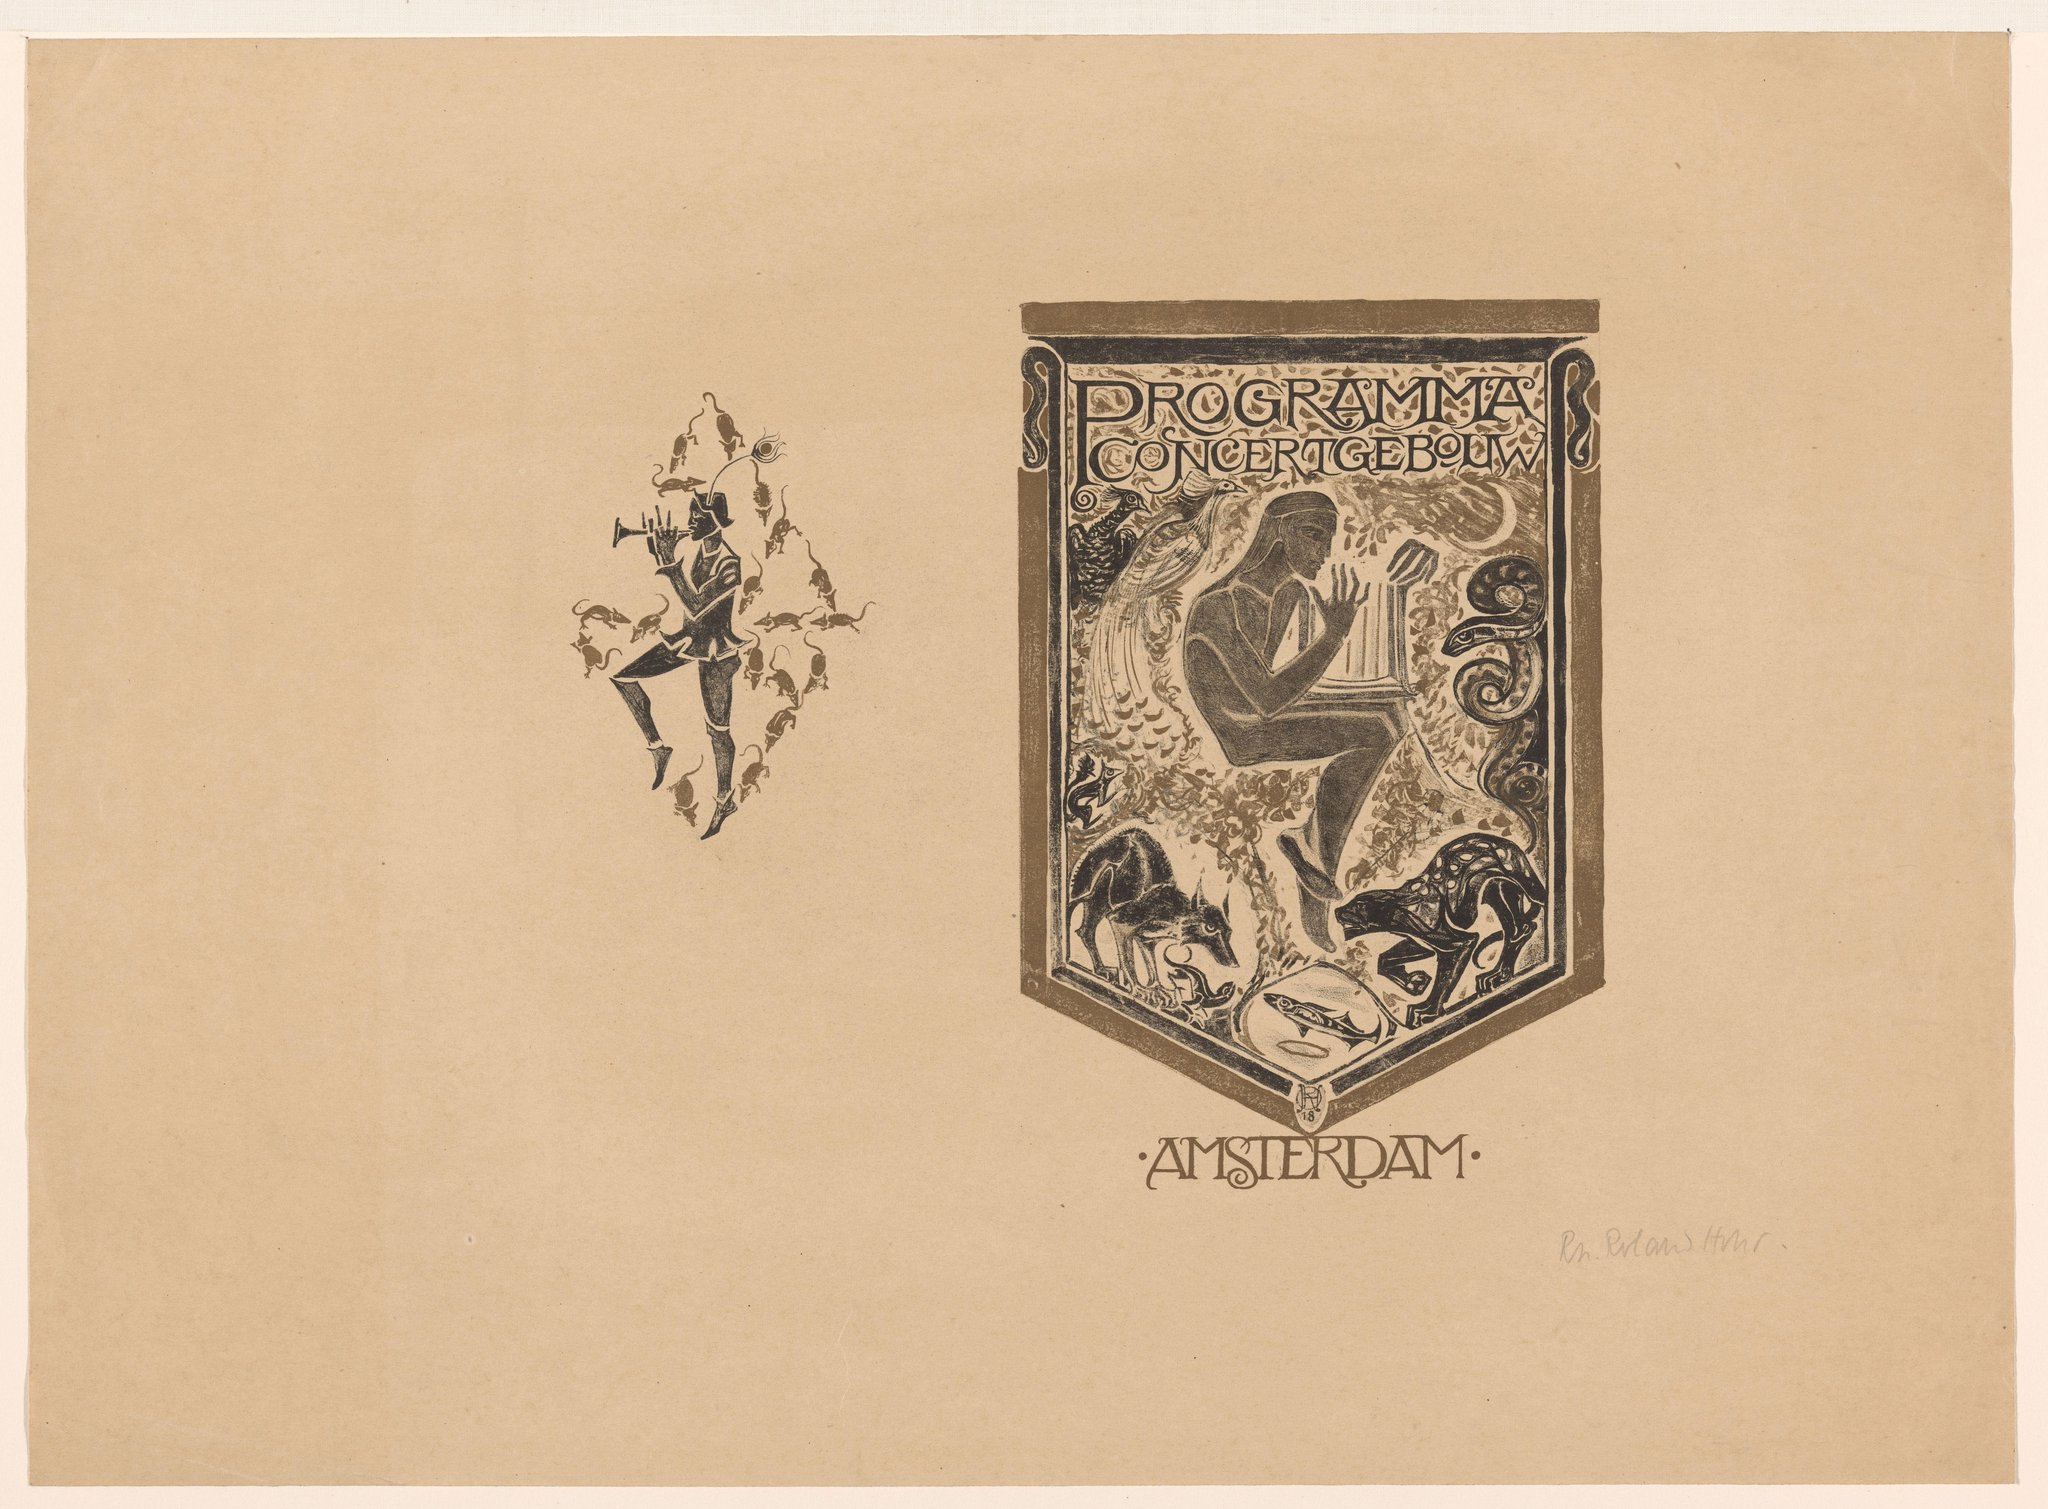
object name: print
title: Omslagontwerp voor: Programma van het Concertgebouw Amsterdam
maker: richard nicolaüs roland holst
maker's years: 1868-1938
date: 1918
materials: paper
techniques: lithograph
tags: musician, animals, orpheus playing the lyre: trees and rocks move, beasts and birds are enchanted, rat exterminator, tales and fairy tales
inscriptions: collector's mark: Lugt 2228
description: Links de rattenvanger van Hamelen die zijn fluit bespeelt. De ratten die hij zodoende lokt zijn in een ruitvorm om hem heen geplaatst. Rechts Orpheus die op zijn harp speelt in het gezelschap van verschillende dieren.